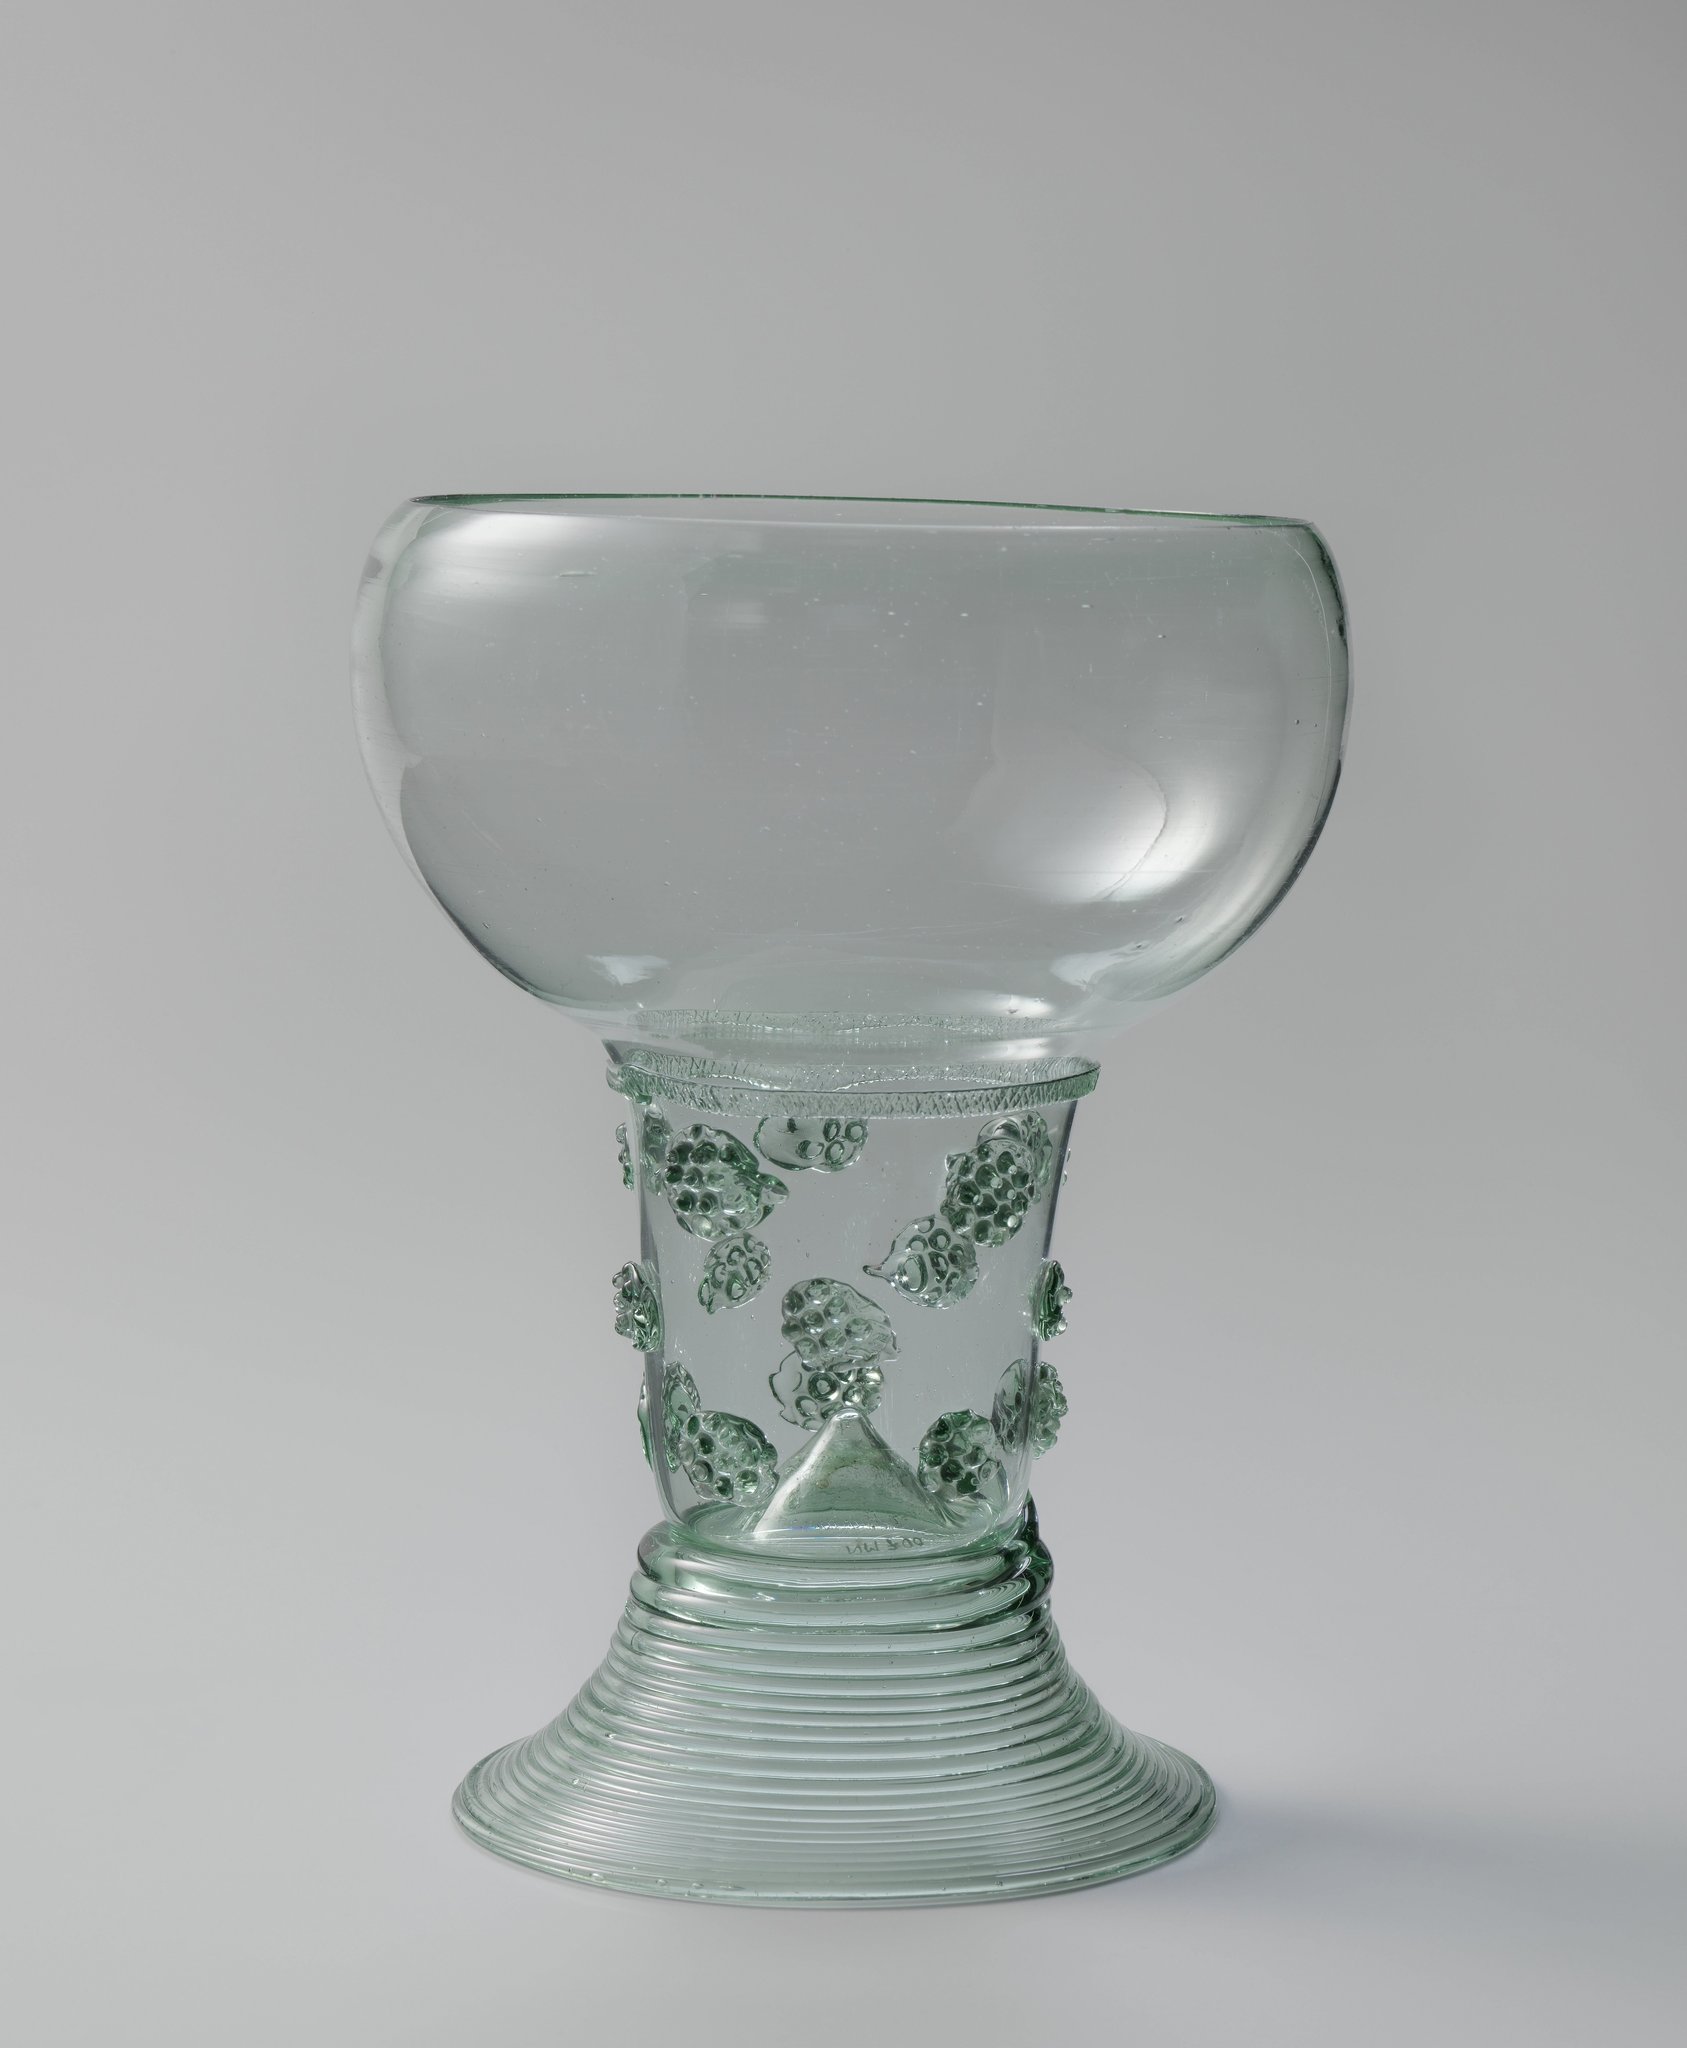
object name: roemer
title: Roemer with three rows of raspberry prunts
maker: Anonymous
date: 1675-1700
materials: glass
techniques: glassblowing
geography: germany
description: The Netherlands or Germany, c. 1675–1700 glass